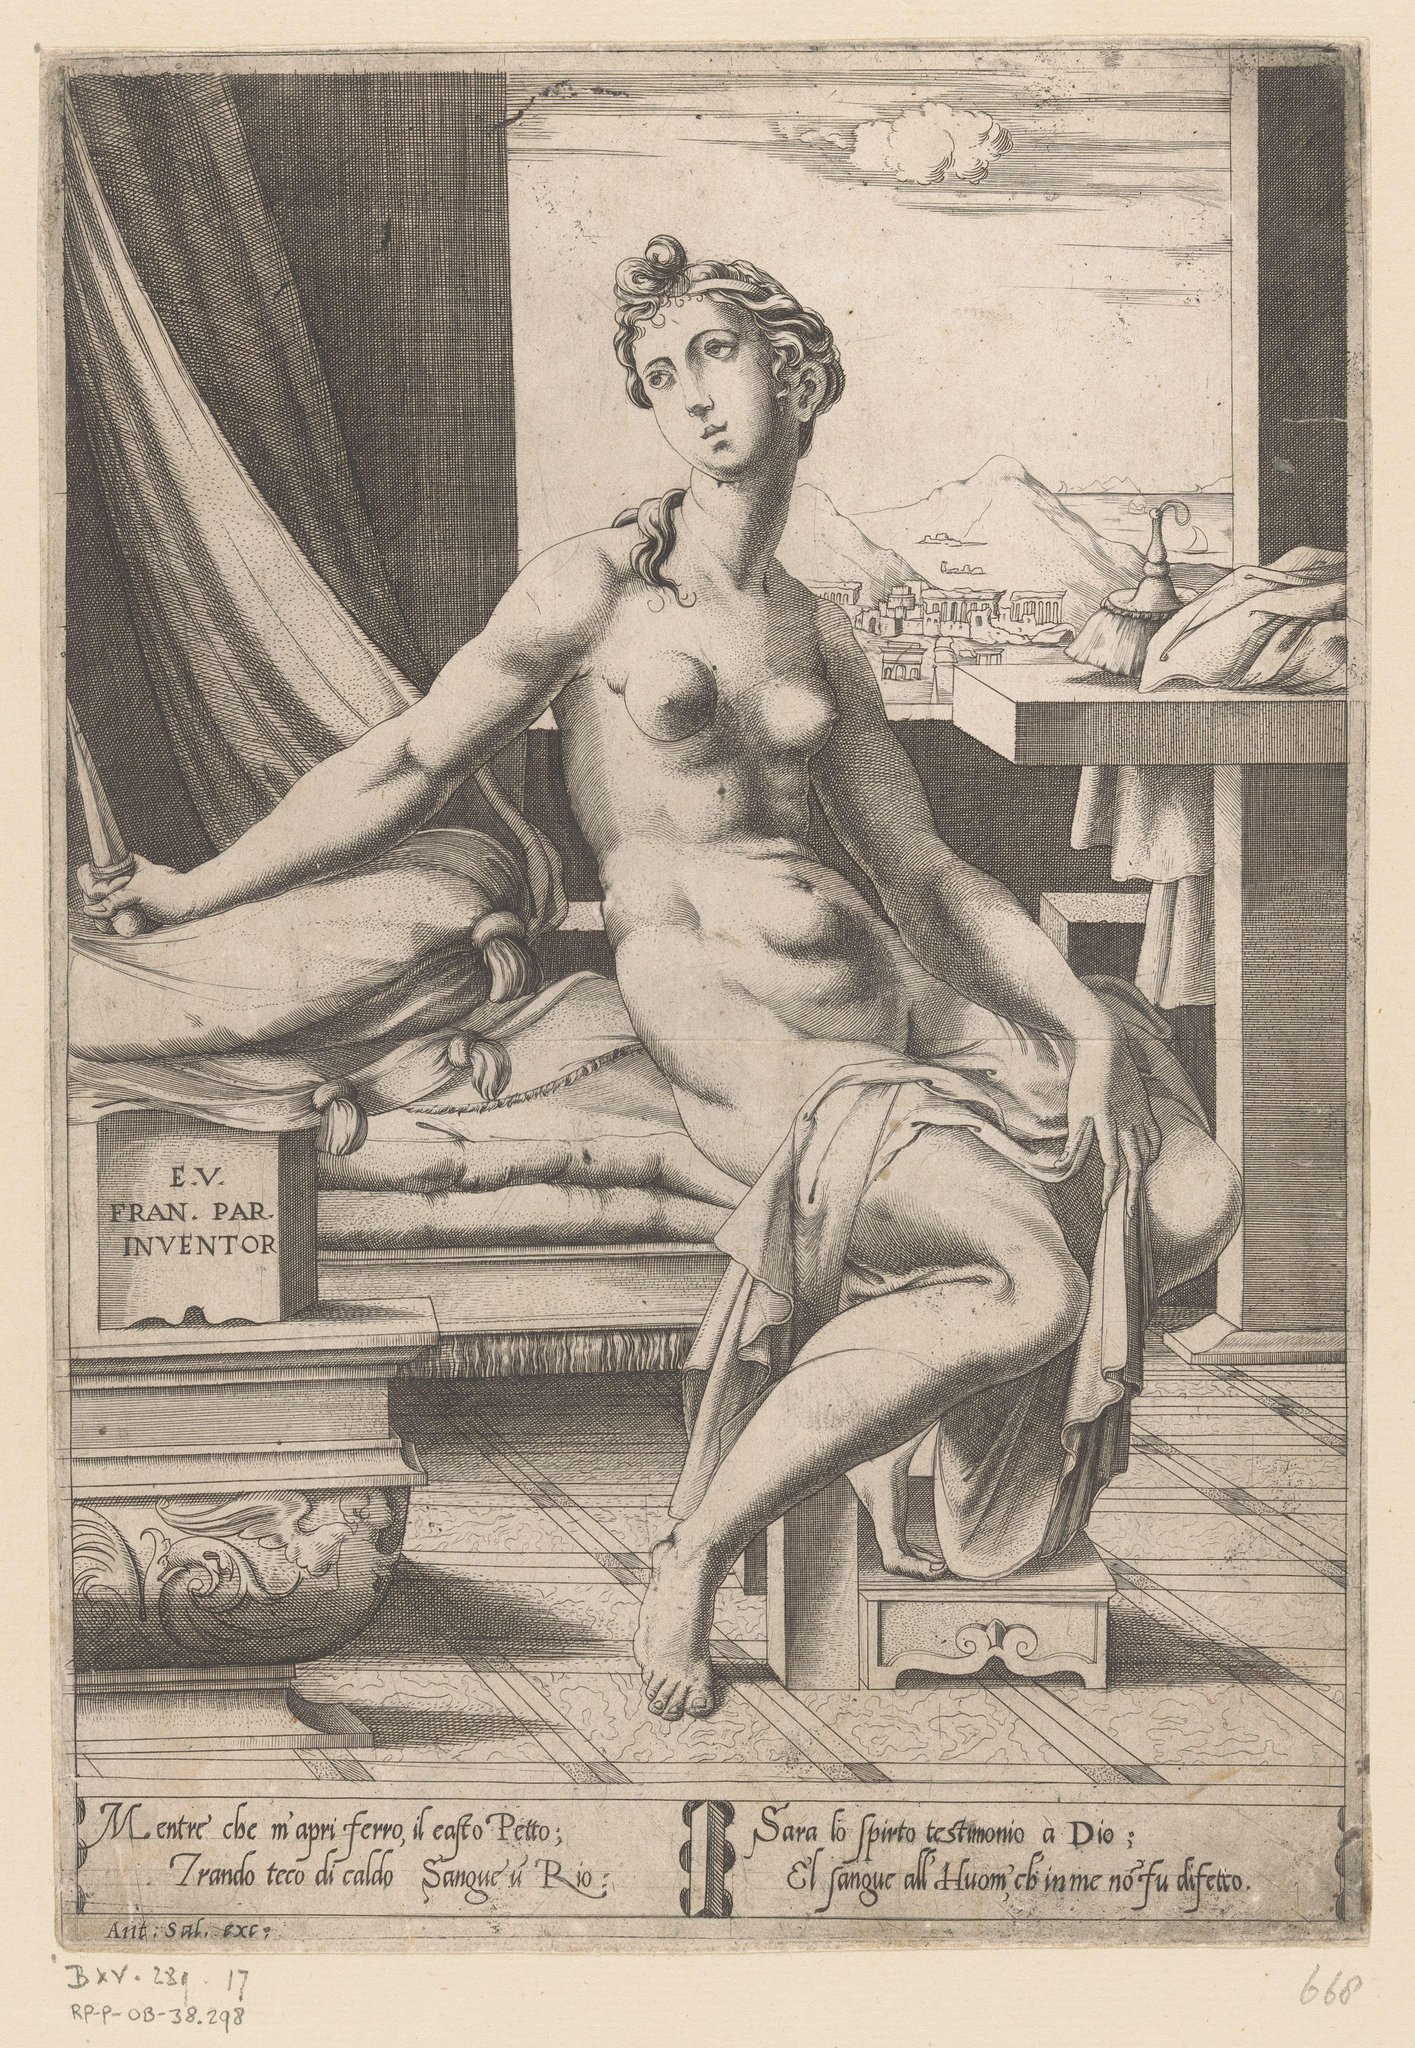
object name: print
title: Zelfmoord van Lucretia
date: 1533-1567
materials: paper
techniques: engraving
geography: rome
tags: city-view, and landscape with man-made constructions, death of lucretia: she commits suicide by stabbing herself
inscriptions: collector's mark: Lugt 240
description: Lucretia zit op een bed met in haar hand de dolk waarmee zij zich zal doorsteken. Rechts een raam met uitzicht op een landschap. Italiaanse tekst in twee kolommen in ondermarge.